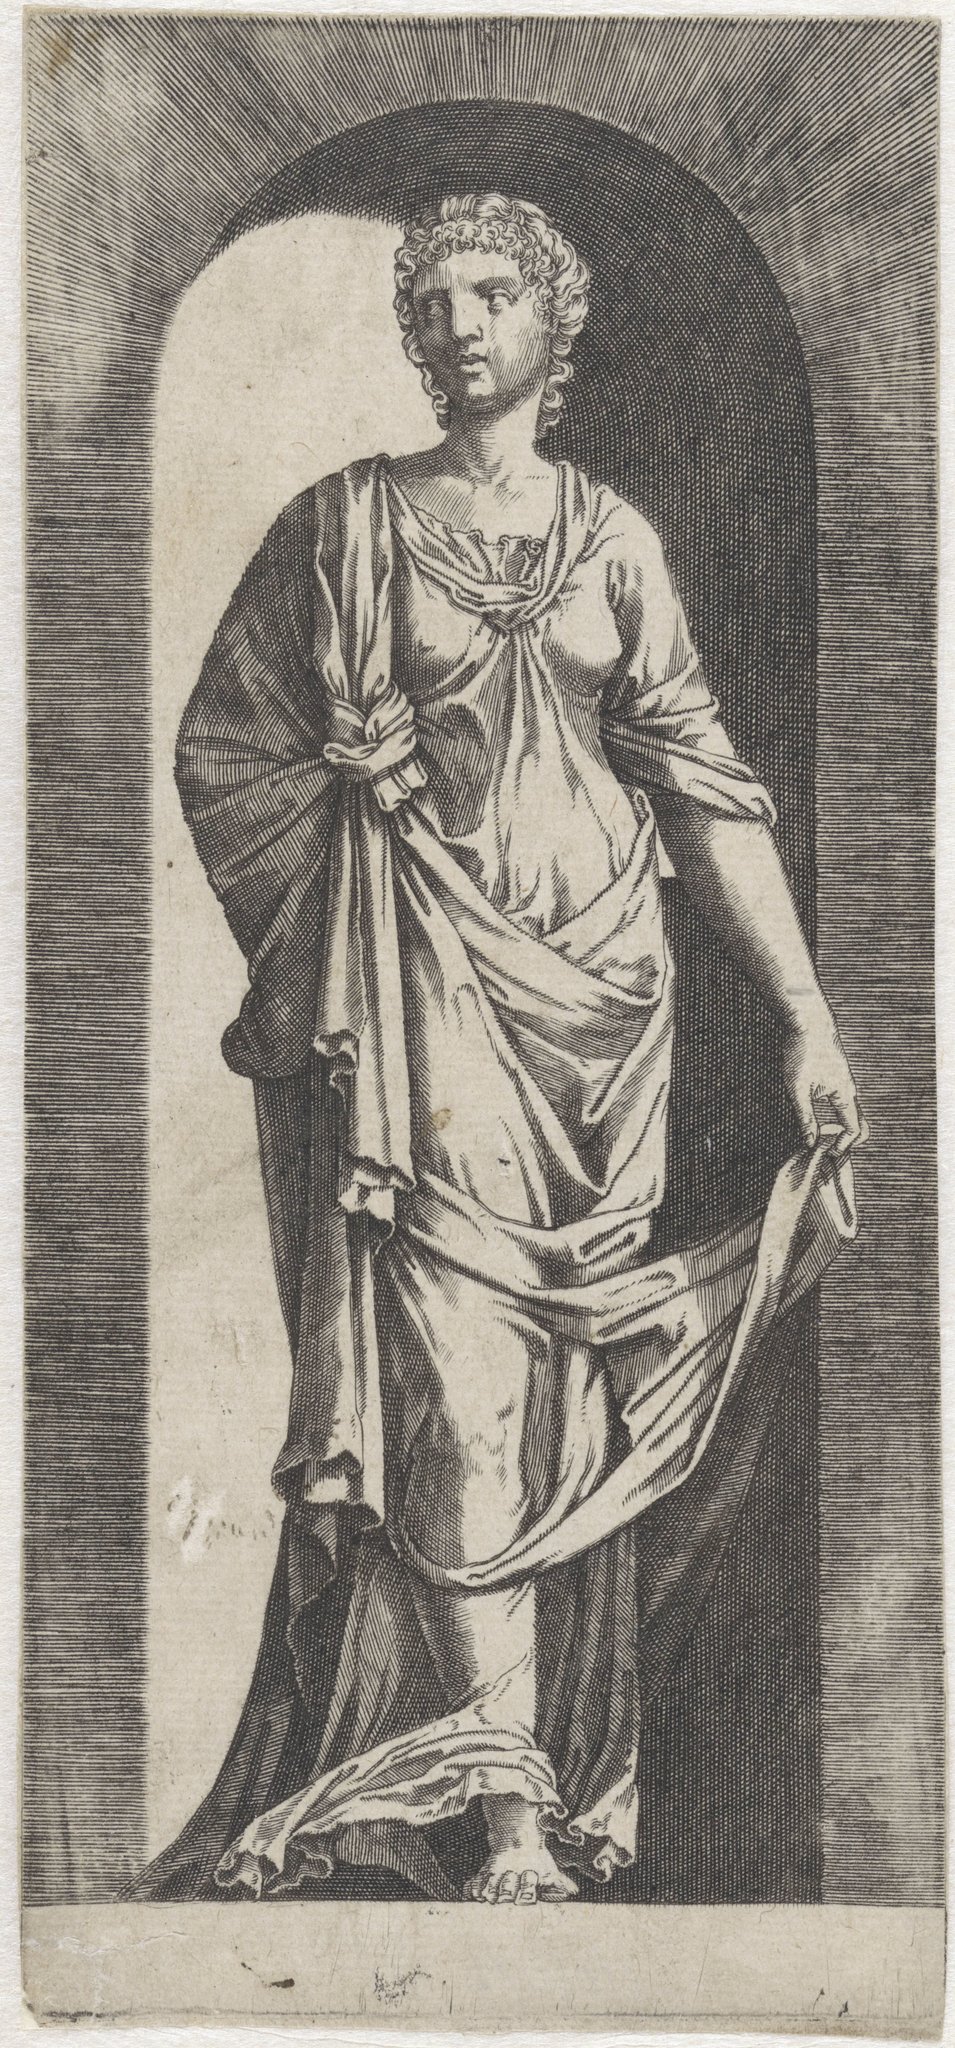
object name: print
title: Sibillen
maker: lambertus suavius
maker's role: print maker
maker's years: 1514-1564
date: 1520-1567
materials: paper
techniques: engraving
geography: southern netherlands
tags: sibyls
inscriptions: collector's mark: Lugt 2228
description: Een Sibille, staande in een nis, houdt een draperie op met haar linkerhand.